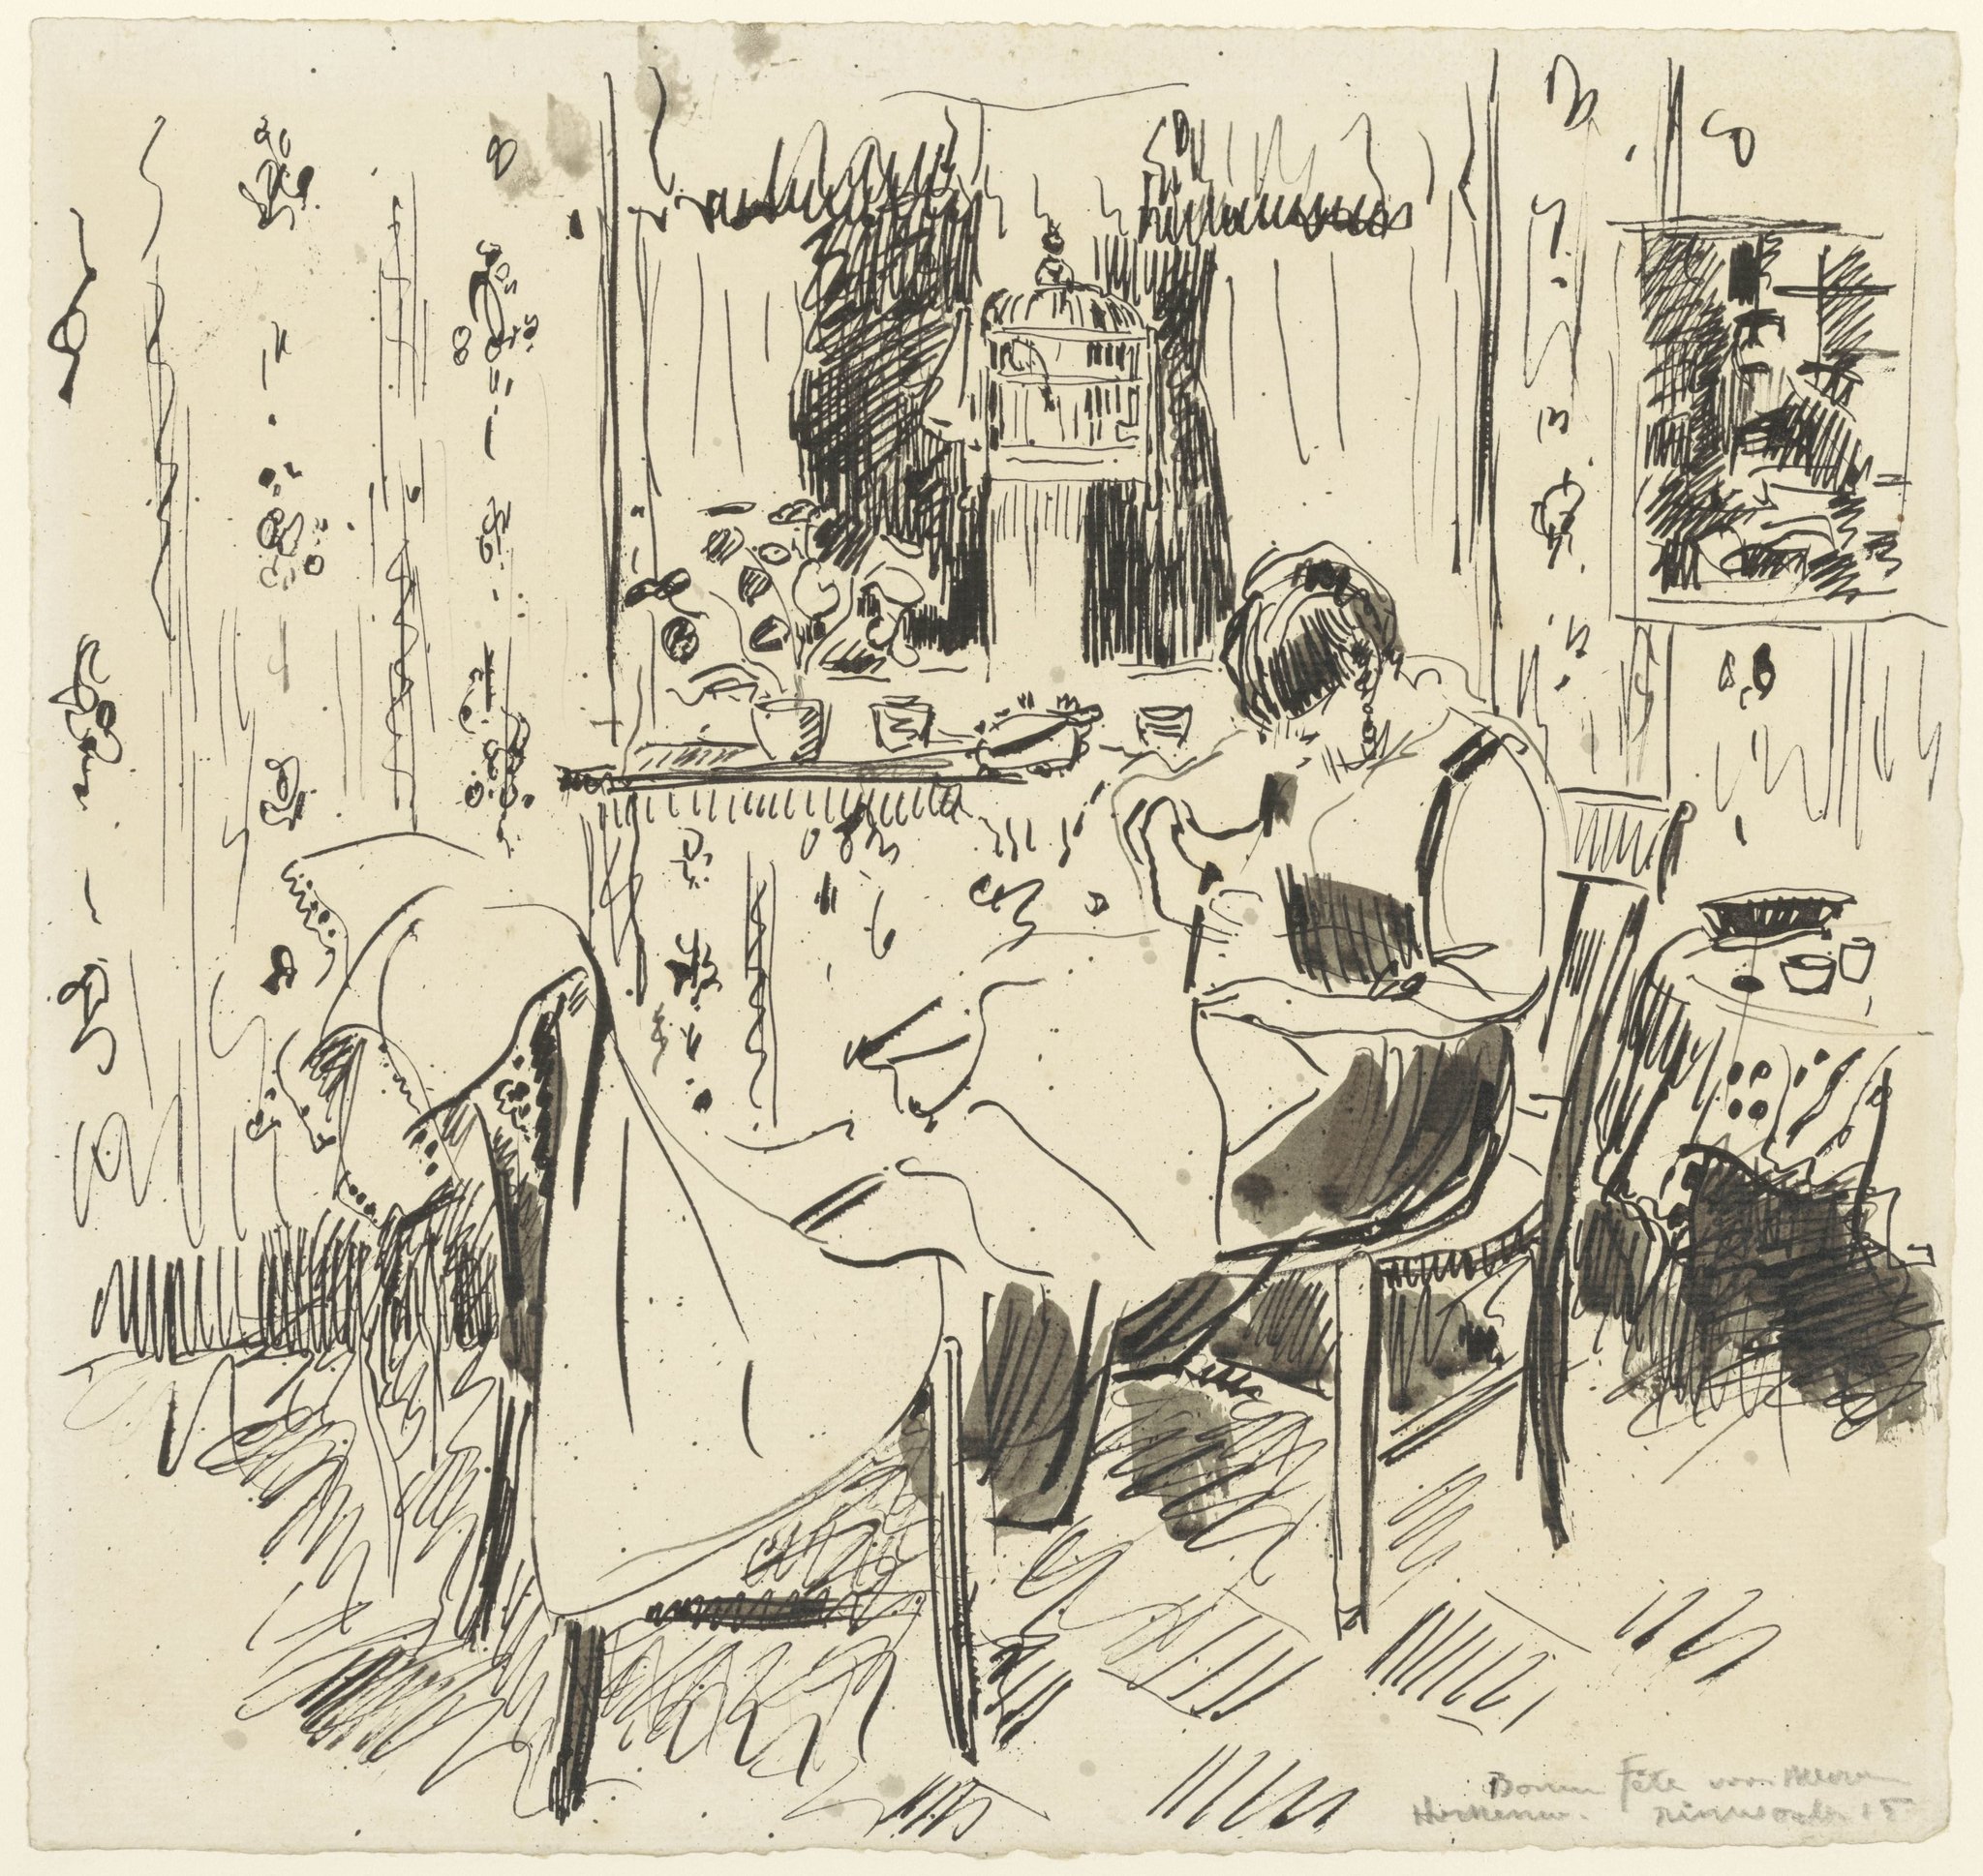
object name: drawing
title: Interieur met een vrouw, die stof voor een kostuum snijdt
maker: rik wouters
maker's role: draughtsman, print maker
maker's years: 1882-1916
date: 1915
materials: ink, paper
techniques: brush, pen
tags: sewing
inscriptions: dedication: ‘Bonne fête voor Mevrouw Harkema’, signature and date: ‘Rik Wouters 15’